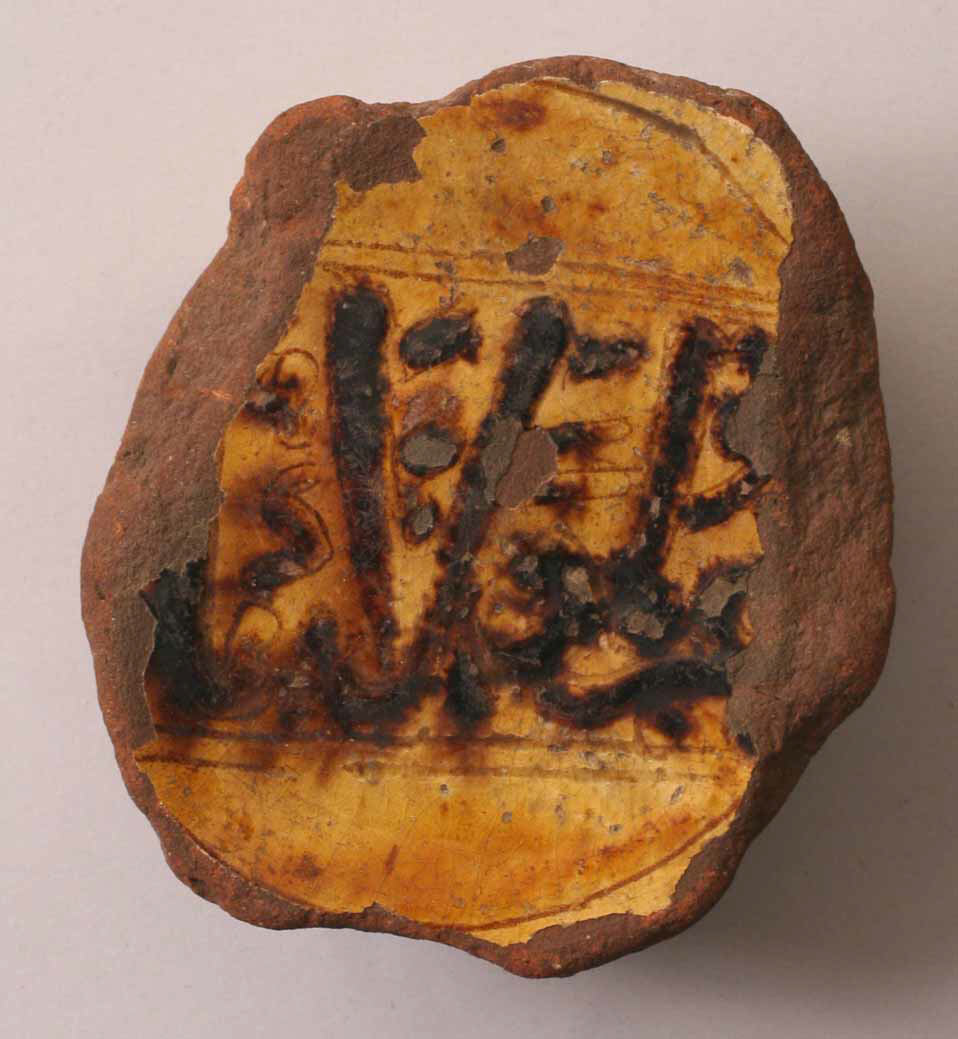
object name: fragment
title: Fragment of a Bowl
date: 1301-1500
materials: earthenware, glaze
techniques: coloring, incising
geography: egypt